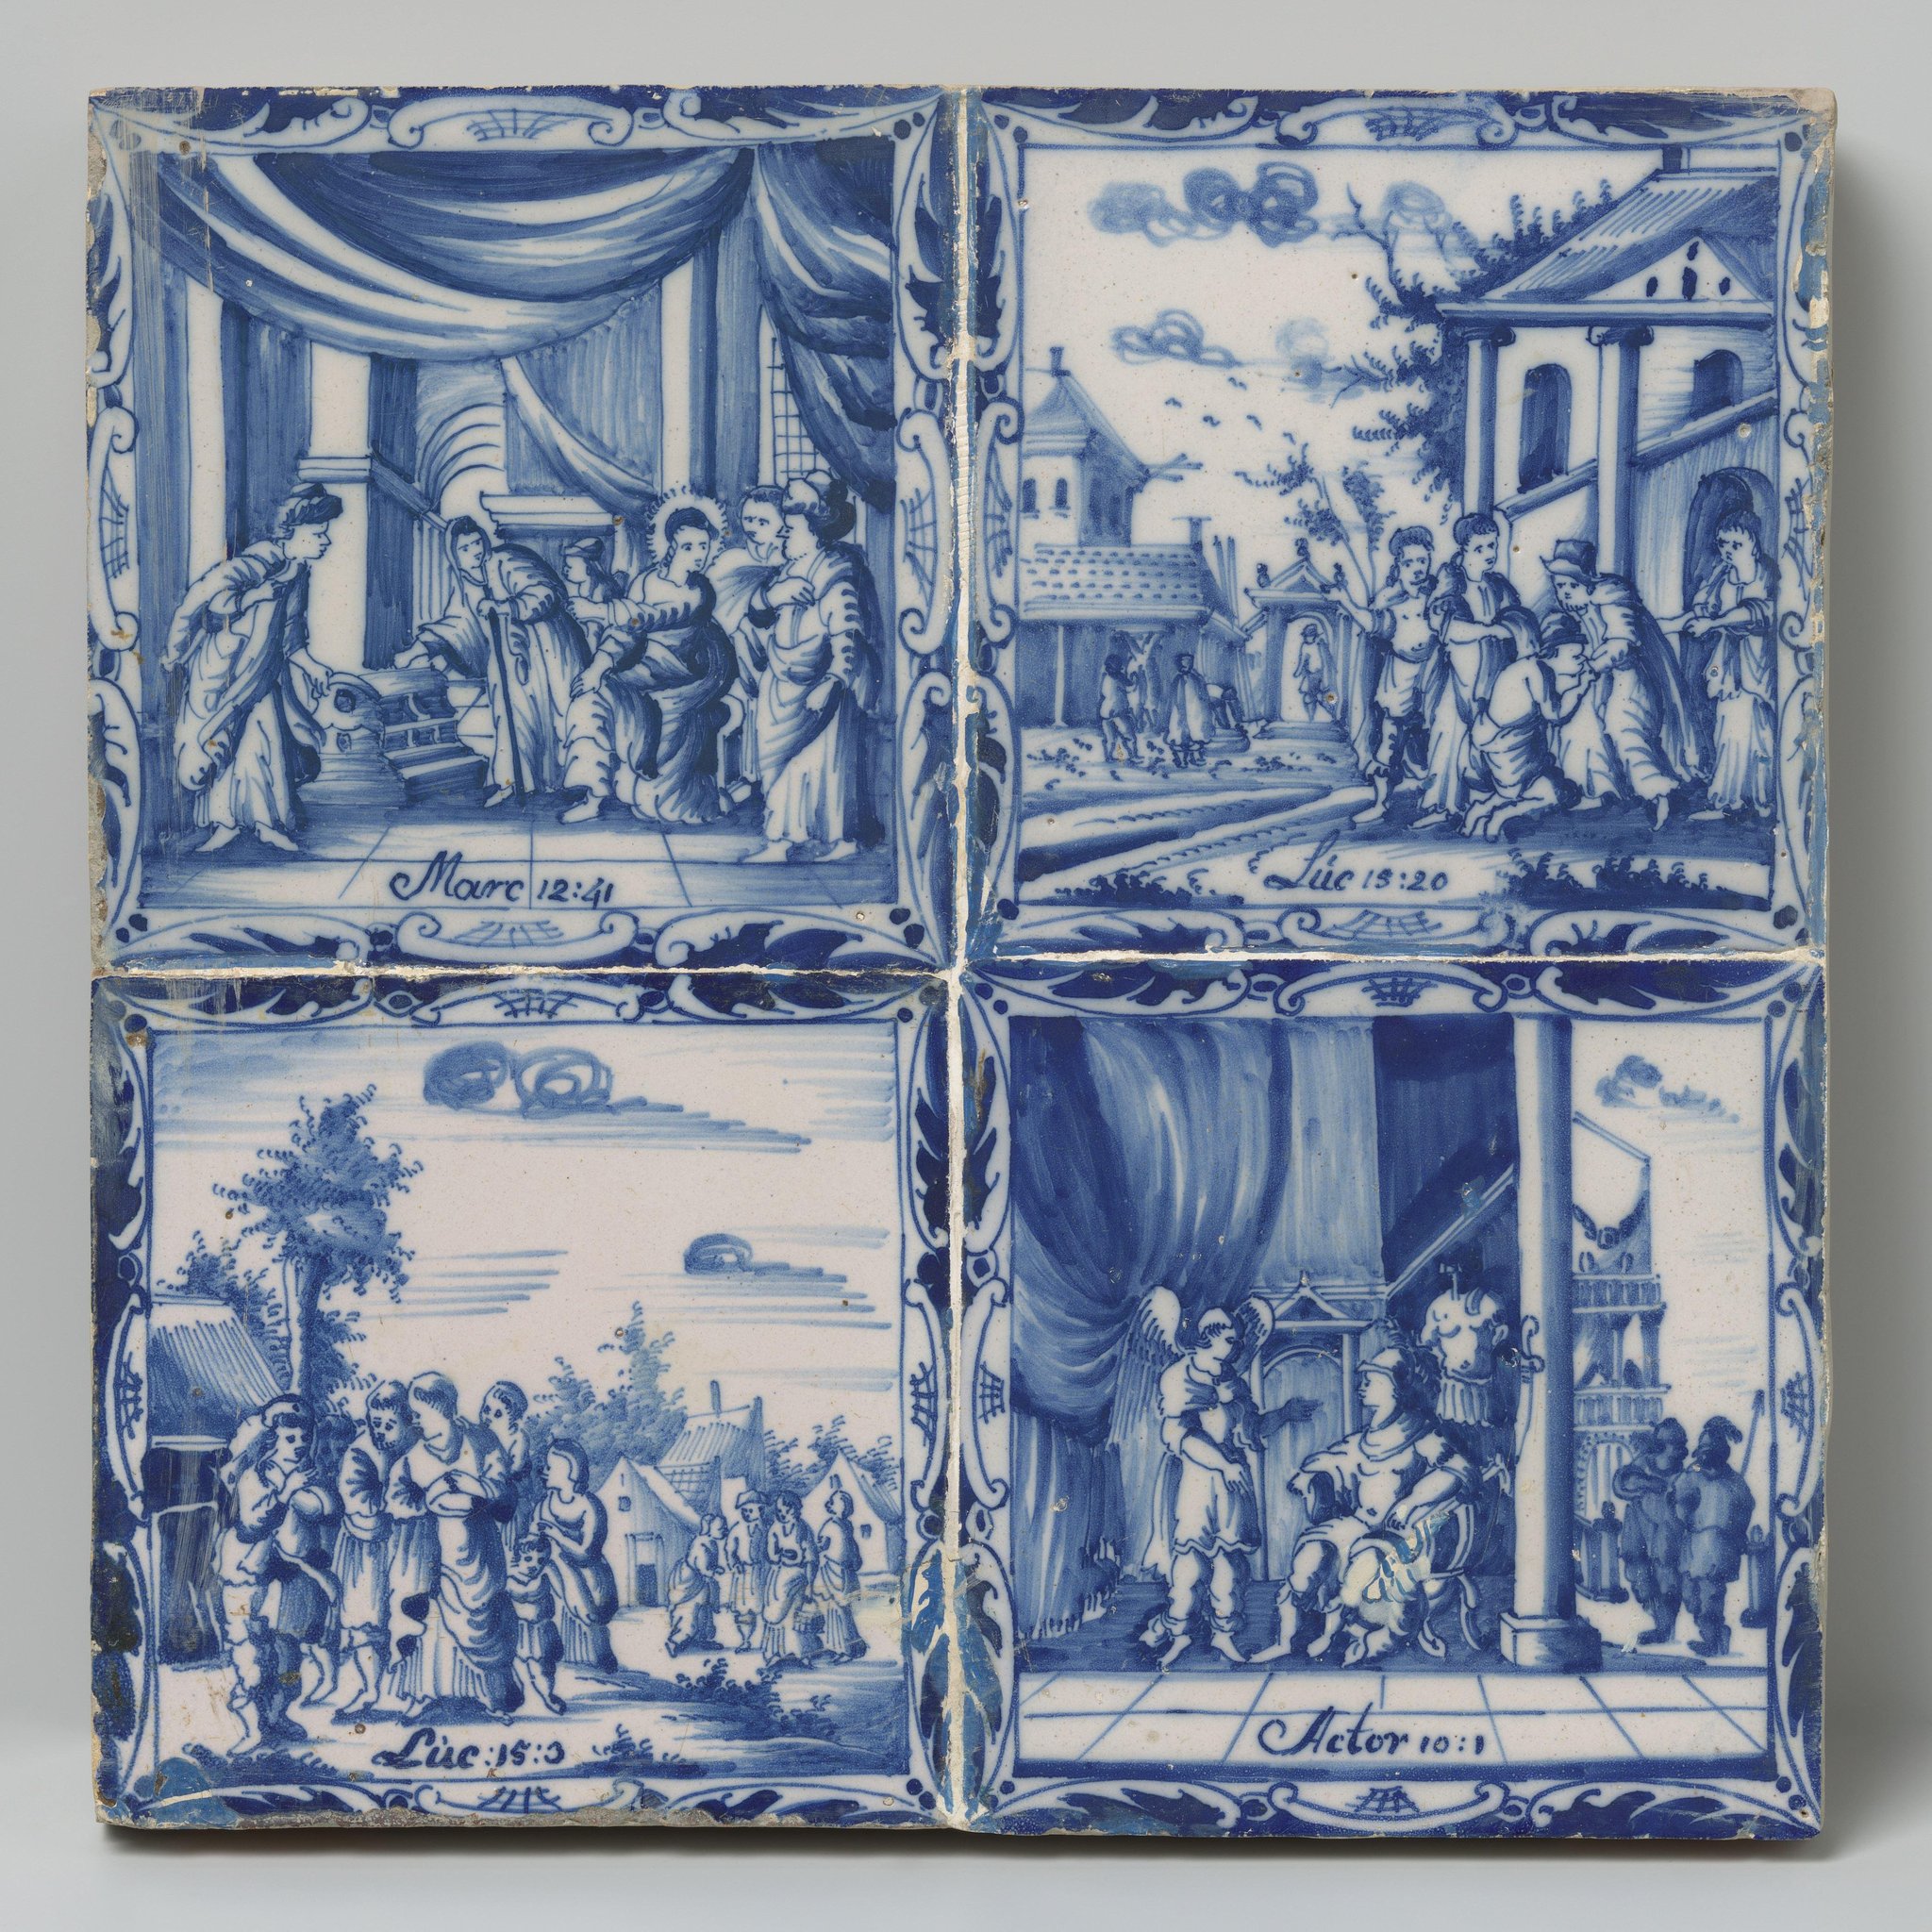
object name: tile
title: Tegel met de parabel van het verloren schaap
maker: Anonymous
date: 1740-1780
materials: earthenware, glaze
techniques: maiolica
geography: netherlands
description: Tegel met een blauw geschilderde bijbelse voorstelling, de parabel van het verloren schaap met het opschrift: Luc: 15:3. De voorstelling is omlijst door bladeren en c-voluten. Deze tegel vormt onderdeel van een veld van 2 x 2 tegels samen met BK-15579, 15581 en 15582.